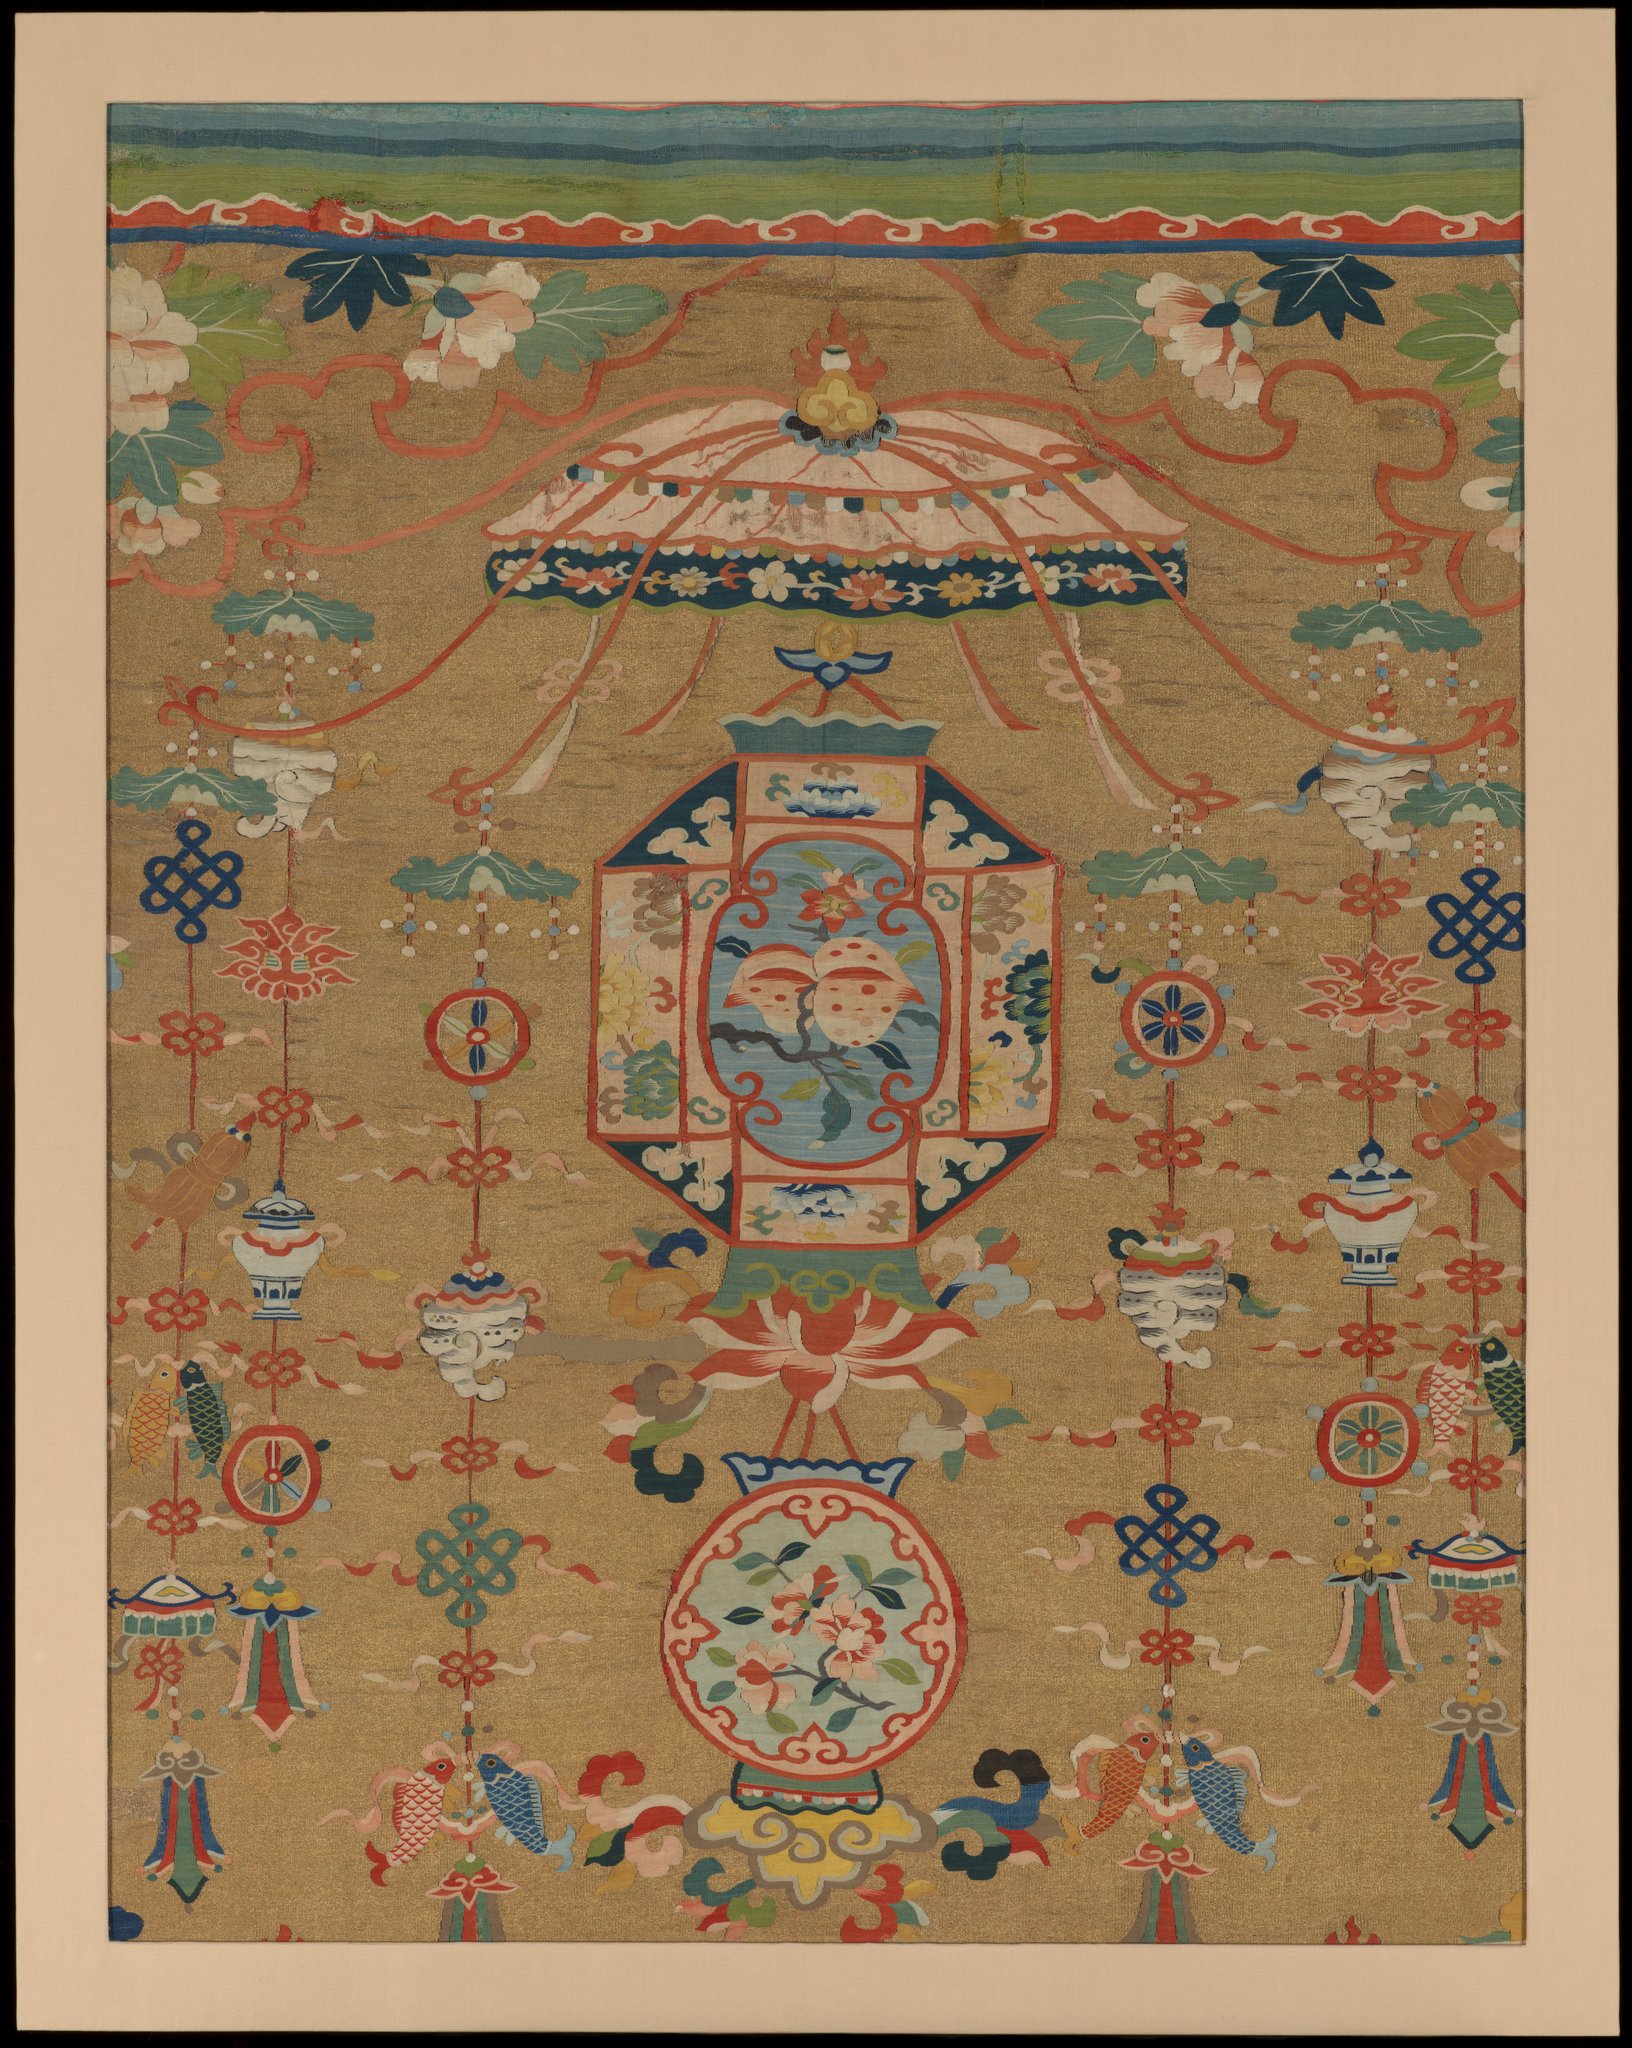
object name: panel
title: Panel with Lantern and Streamers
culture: chinese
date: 1600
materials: metal thread, silk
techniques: tapestry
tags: lanterns